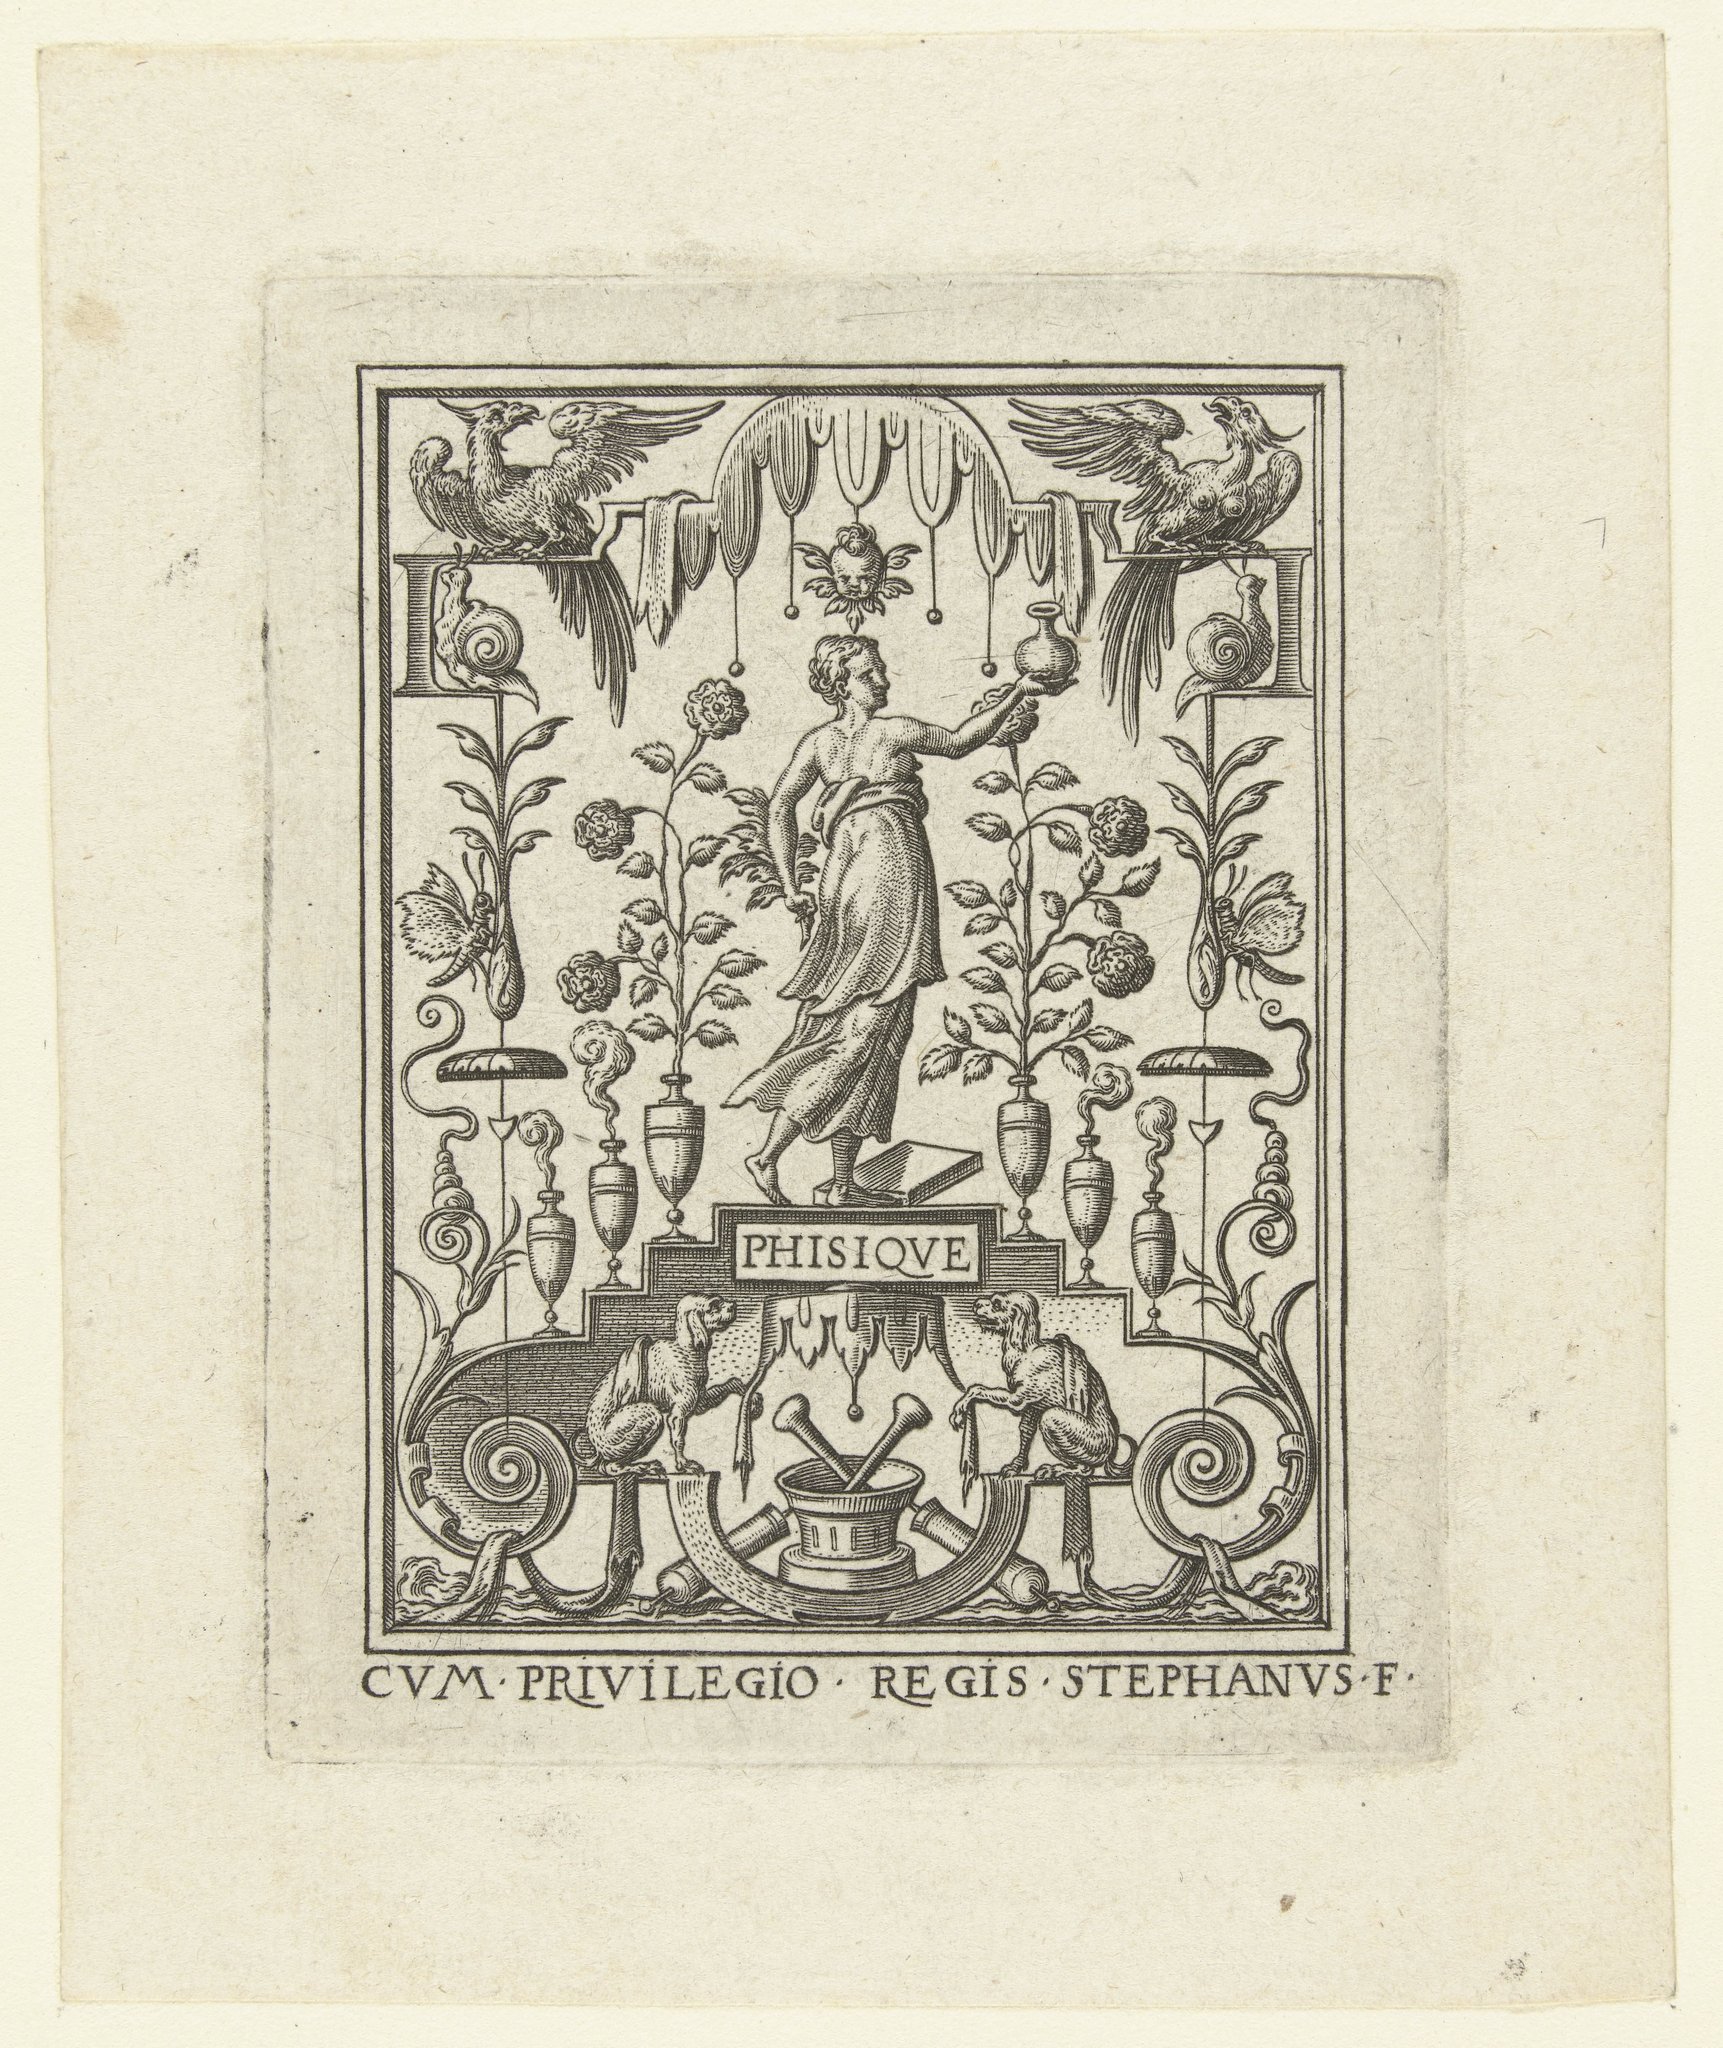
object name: print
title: PHISIQVE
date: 1528-1583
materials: paper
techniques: engraving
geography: france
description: De Fysica met een tak en een vaas, staande onder een baldakijn waarop linksboven en rechtsboven een adelaar zit. Uit serie van 6 bladen.